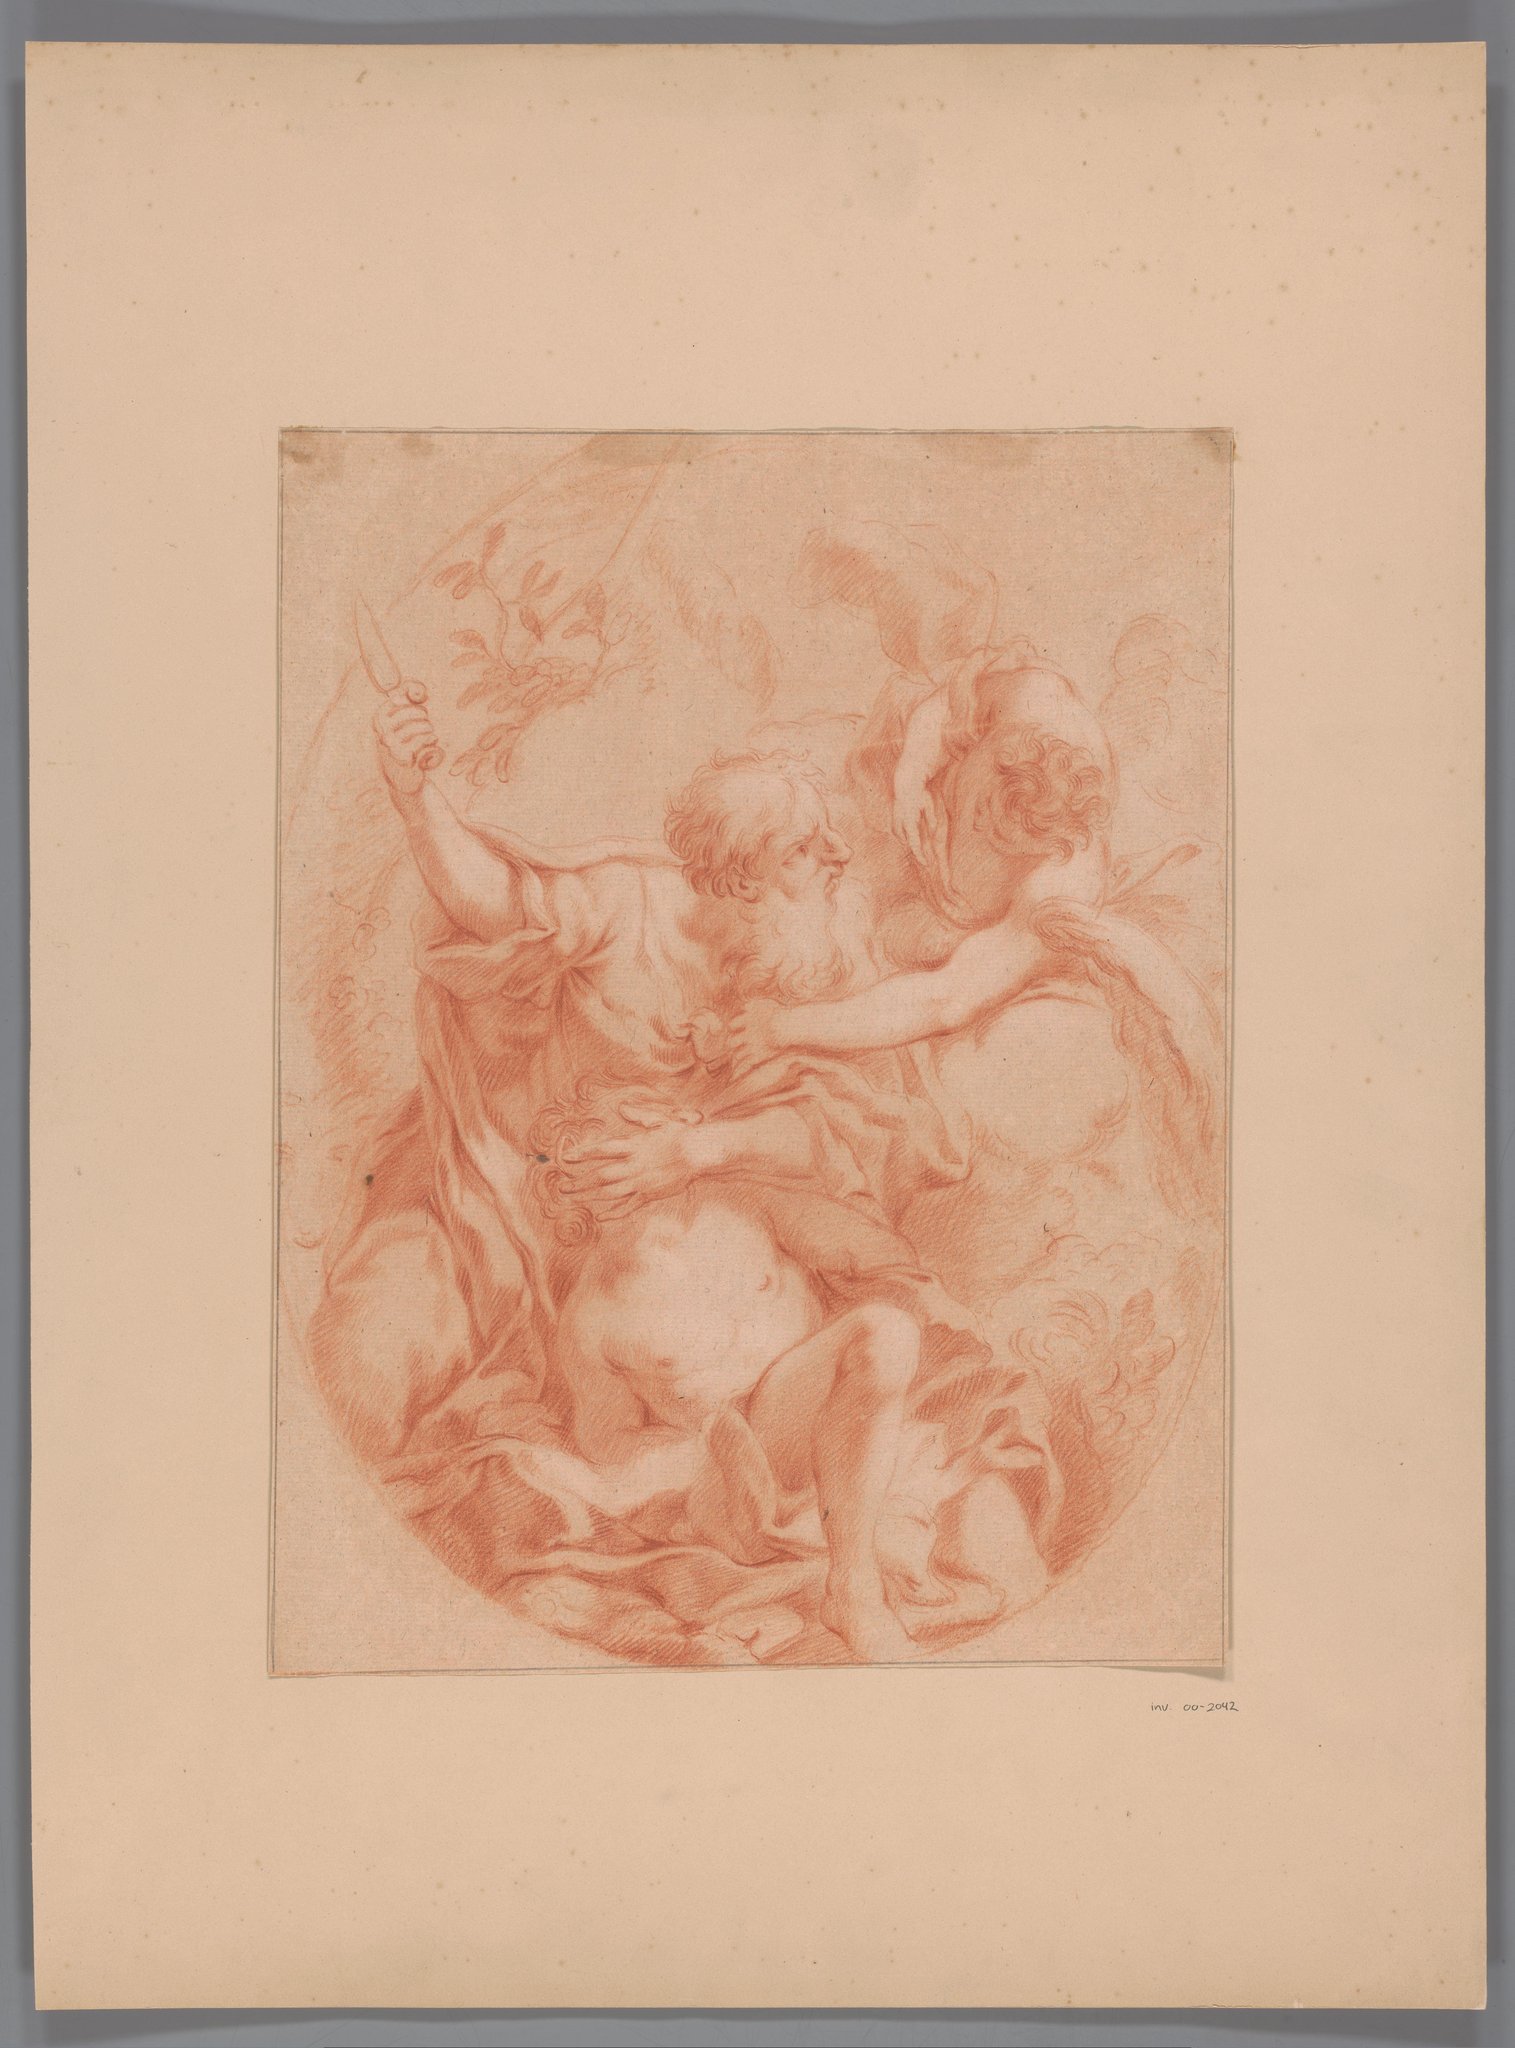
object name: drawing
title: Offer van Abraham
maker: Anonymous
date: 1700-1799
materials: chalk, paper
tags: when abraham has his hand raised to kill isaac, god or the hand of god restrains abraham's hand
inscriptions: number: ‘720’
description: Abraham houdt een mes in de lucht en staat op het punt hiermee zijn zoon Isaak te offeren maar wordt tegengehouden door een engel.